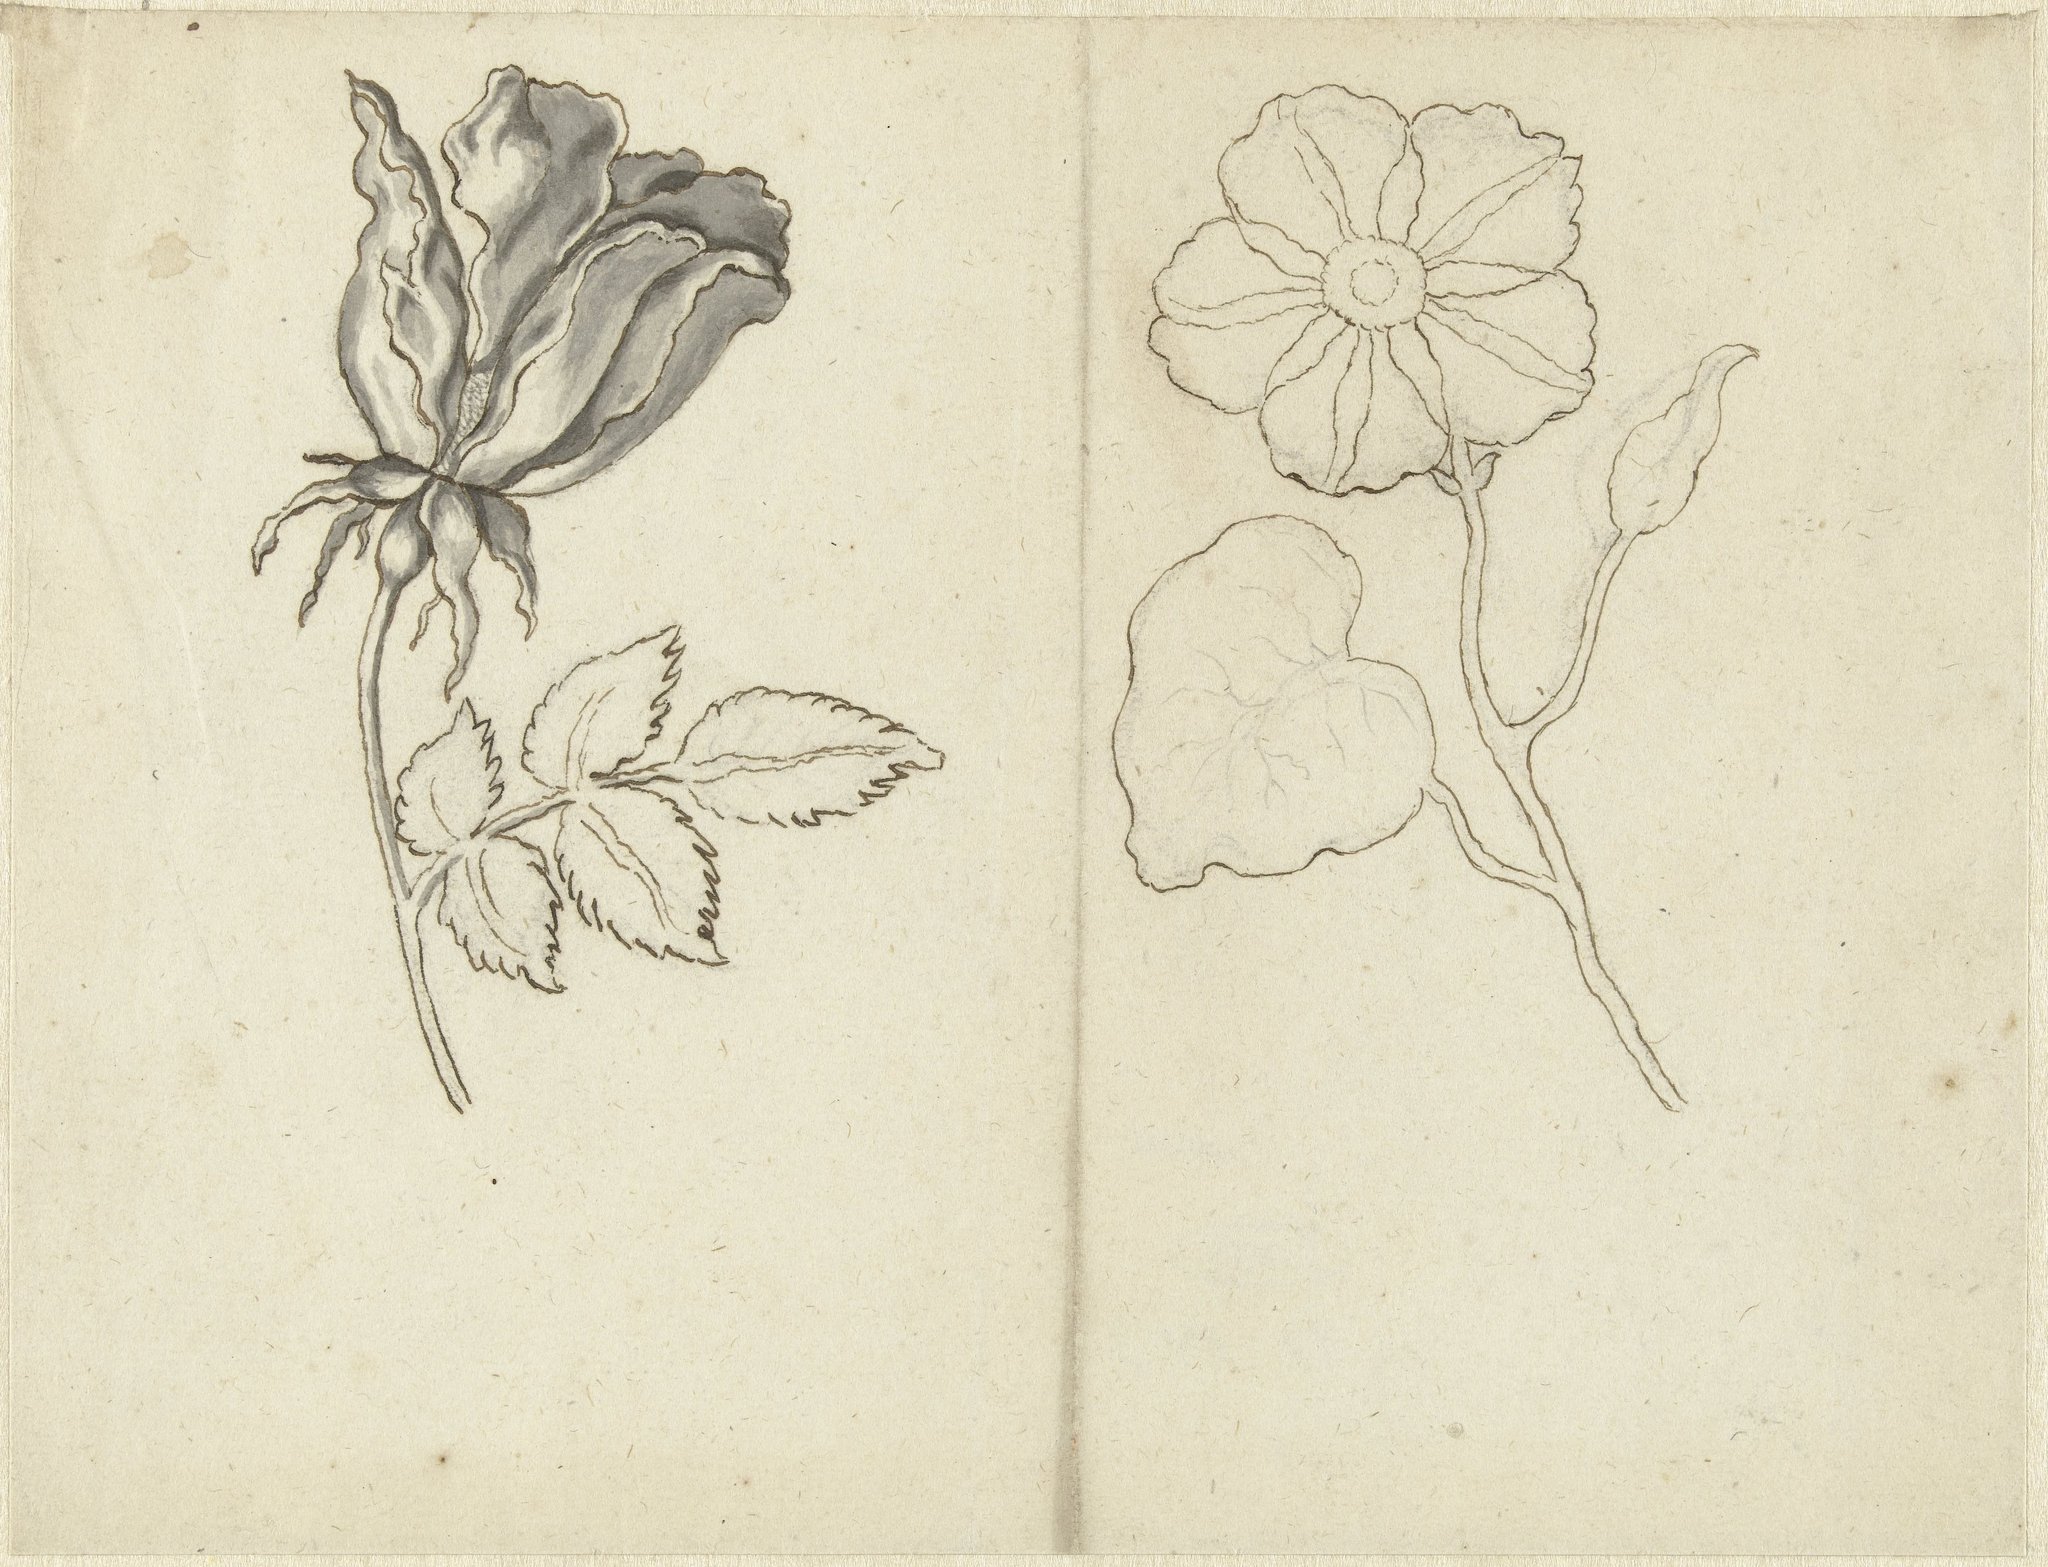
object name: drawing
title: Studieblad met een roos en een ranonkel (?)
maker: bernard picart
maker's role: draughtsman, print maker, publisher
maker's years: 1673-1733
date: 1683-1733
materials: chalk, ink, paper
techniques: brush, pen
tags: flowers: rose, flowers: turban buttercup